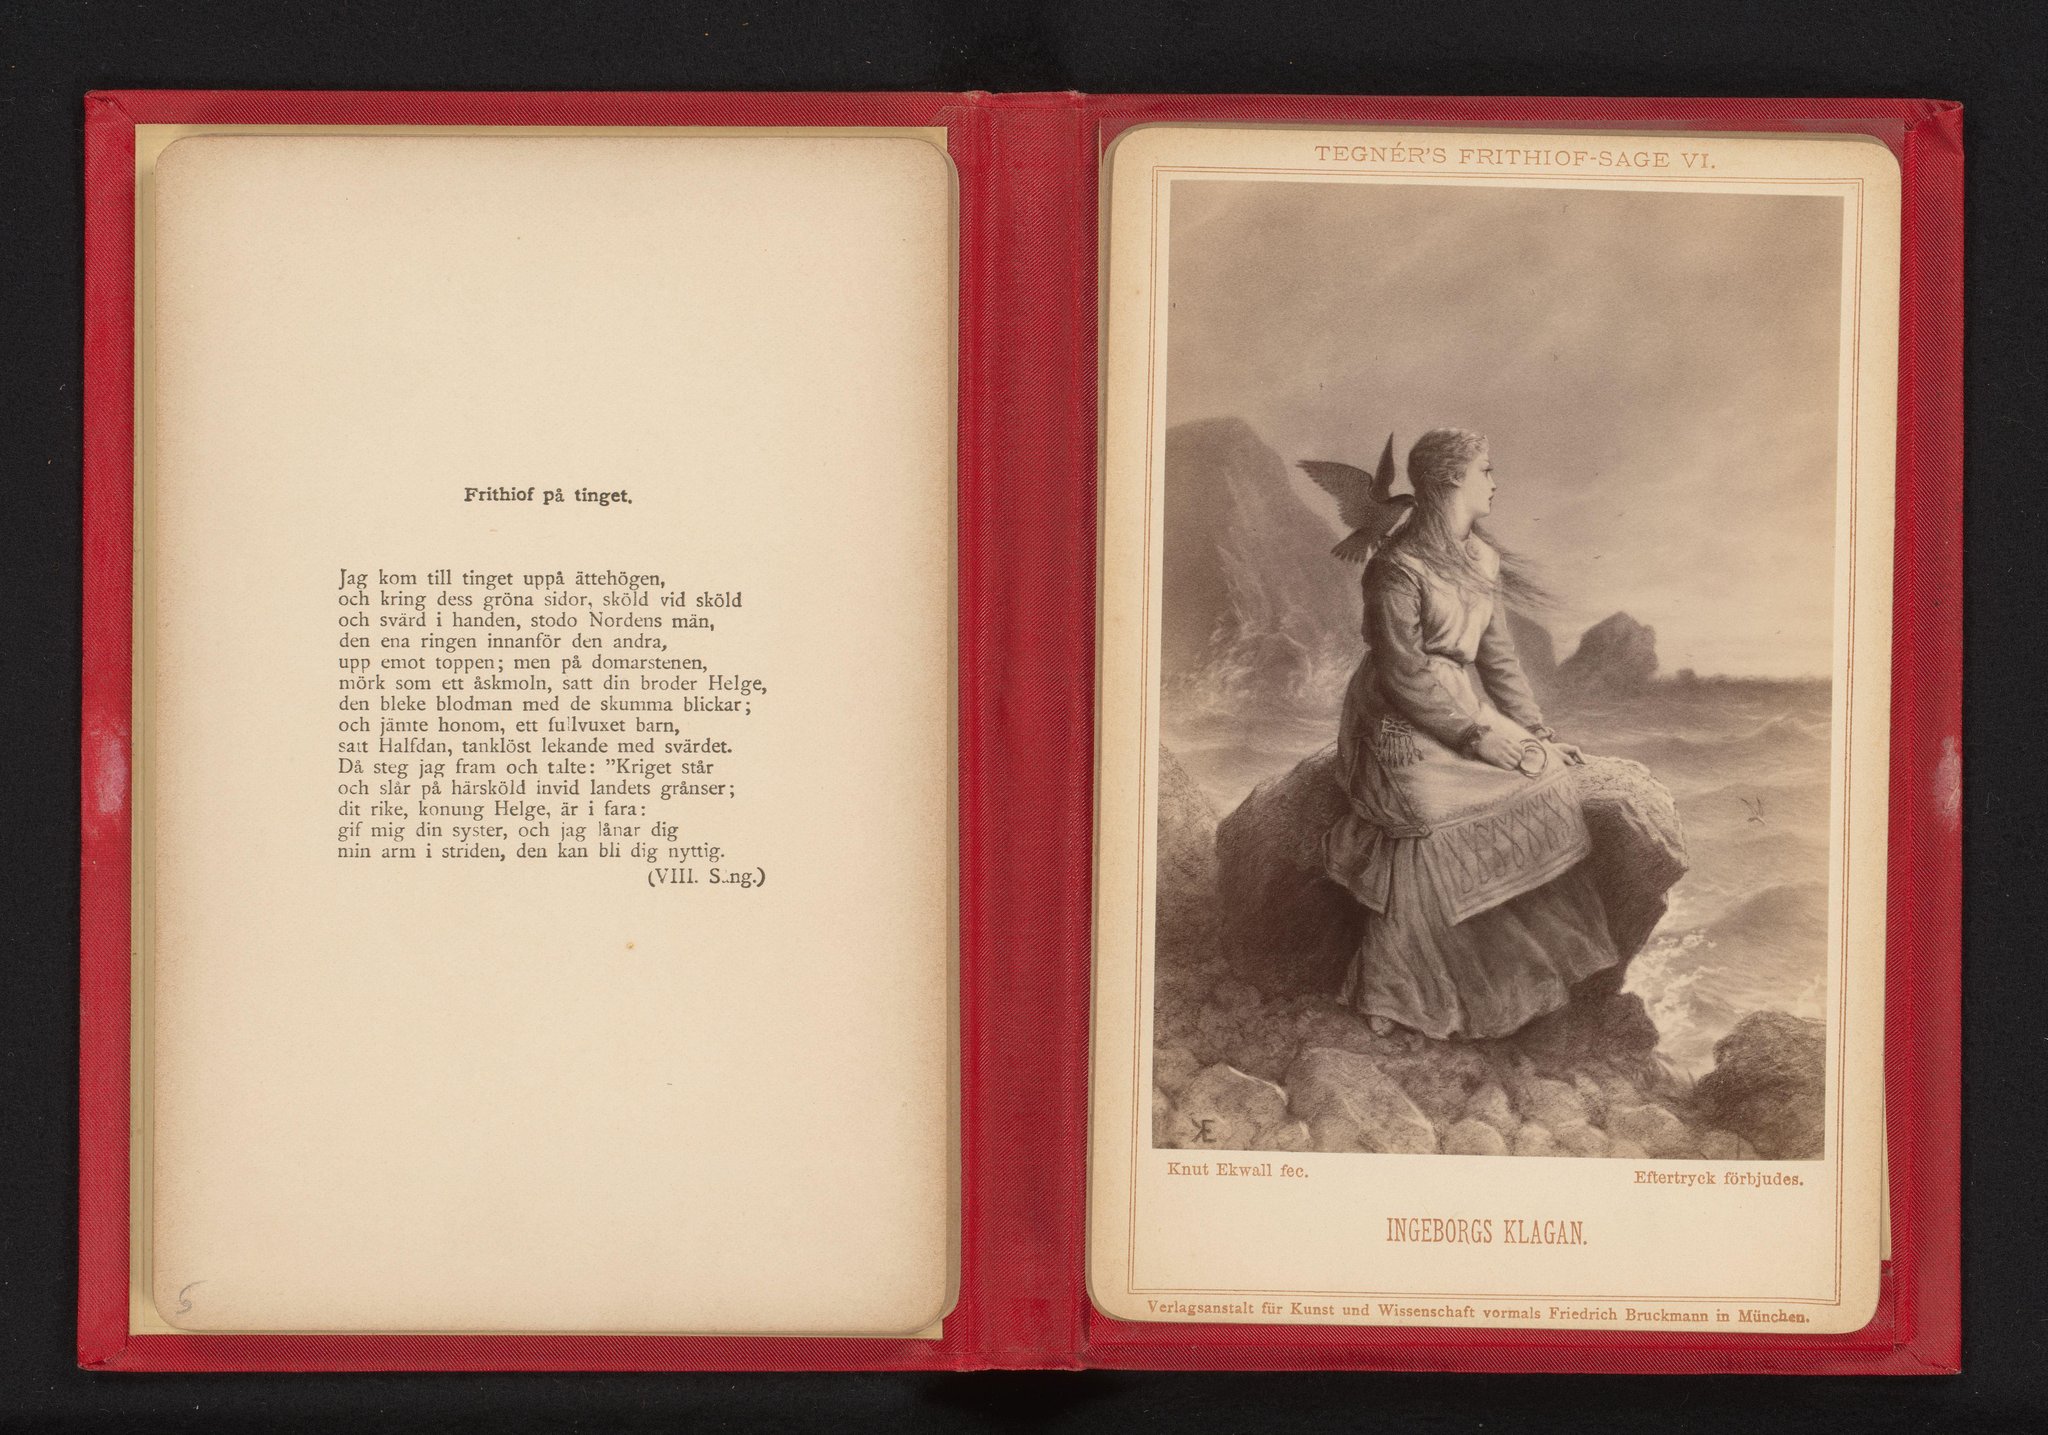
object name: photograph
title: Ingeborgs klagan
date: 1874-1884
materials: photographic support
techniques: albumen print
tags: adult woman, birds, weeping, beach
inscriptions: number: ‘VI.’